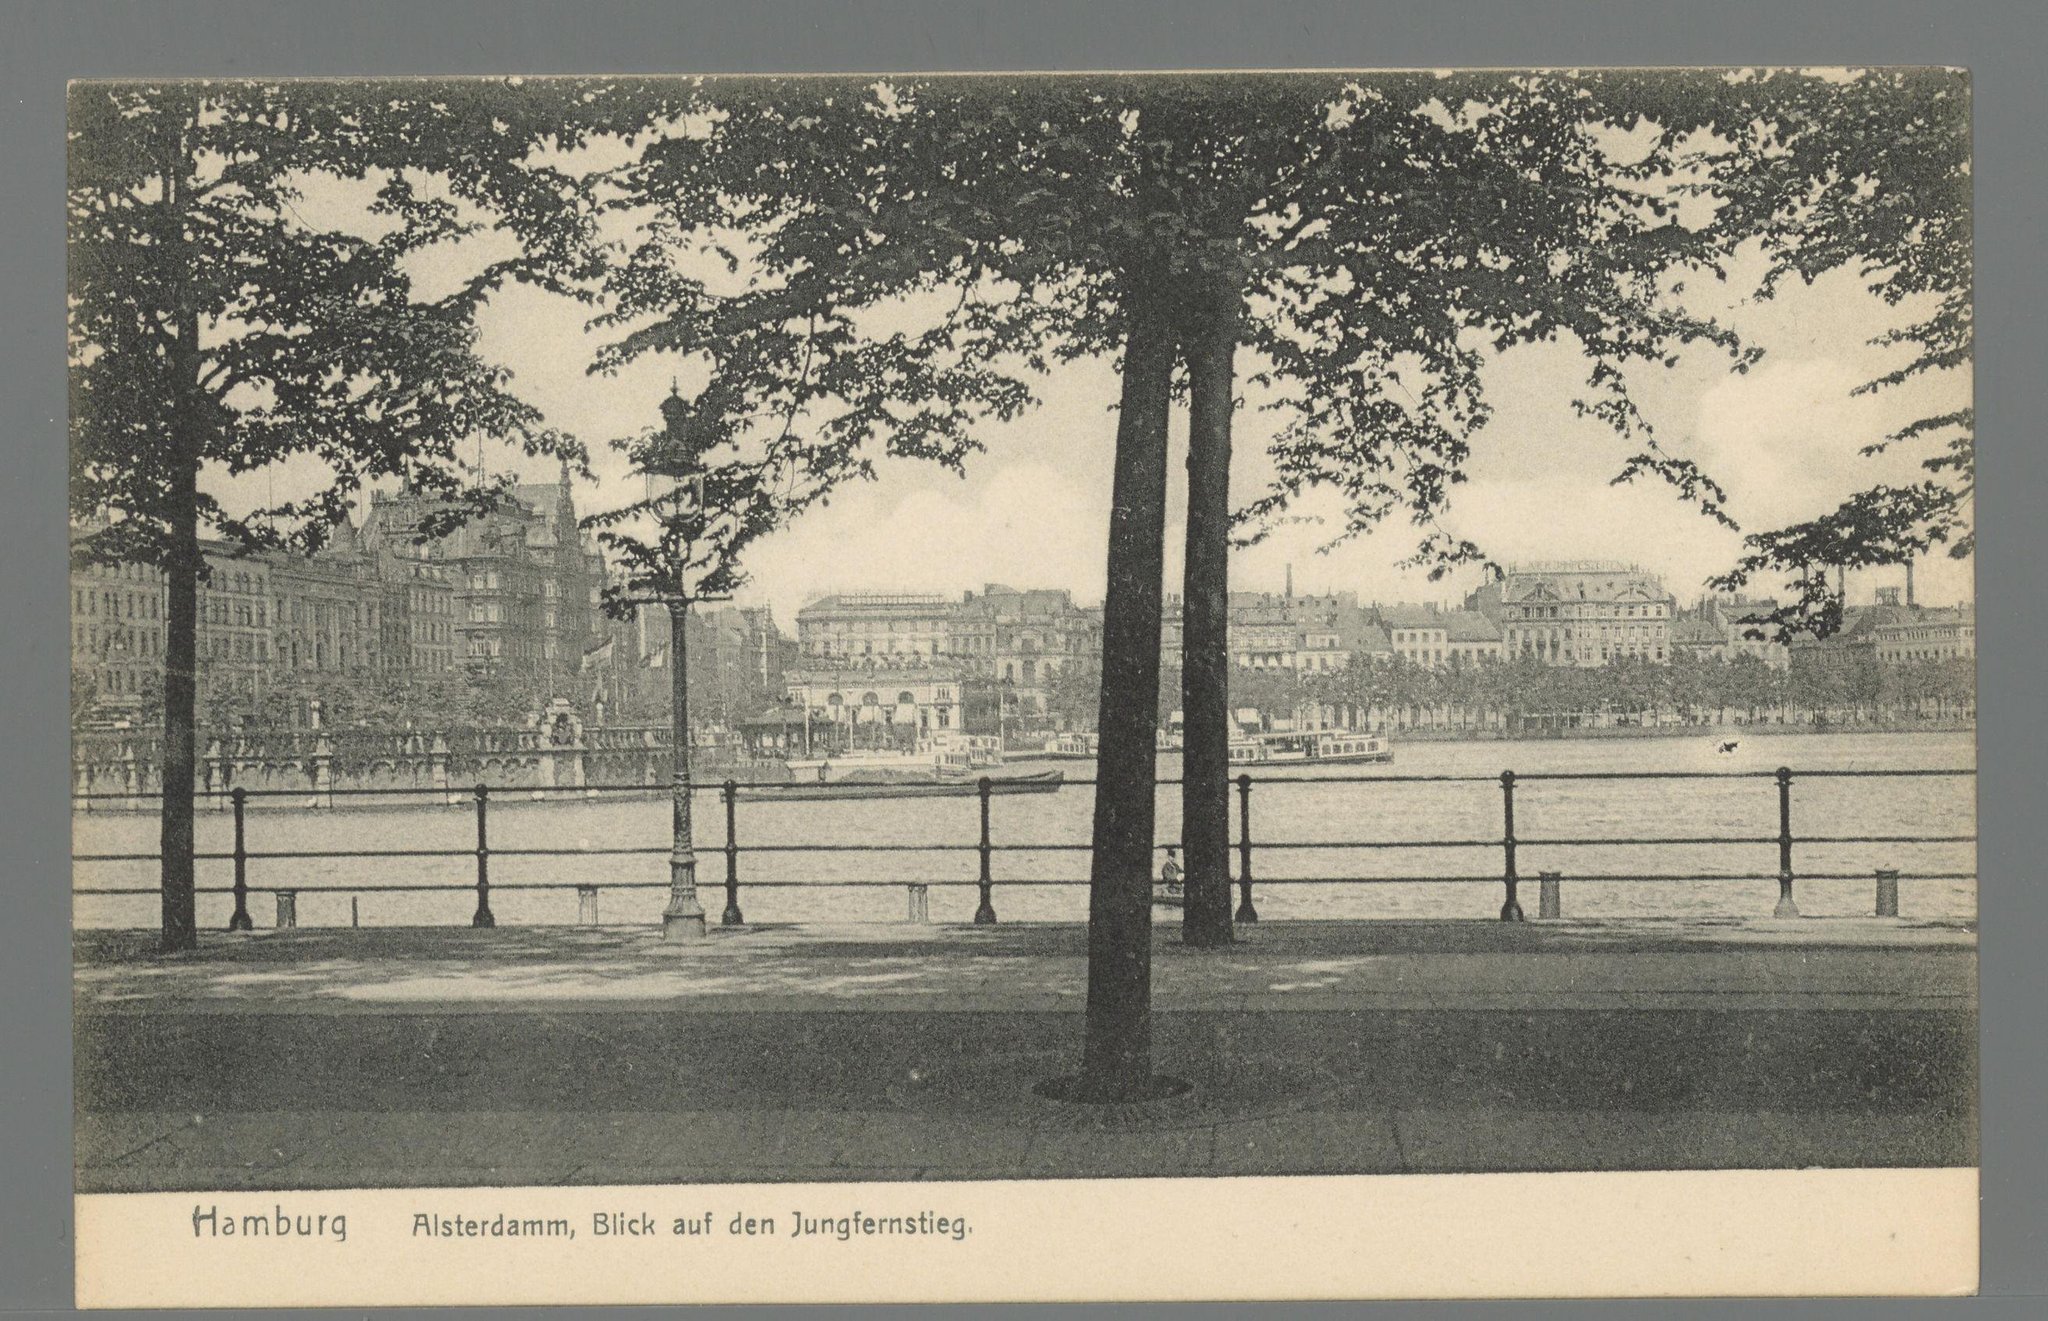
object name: ansichtkaart, prentbriefkaart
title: Hamburg. Alsterdamm, Blick auf den Jungfernstieg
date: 1906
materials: cardboard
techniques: photograph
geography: hamburg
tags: canals, waters (in city), quay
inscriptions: date